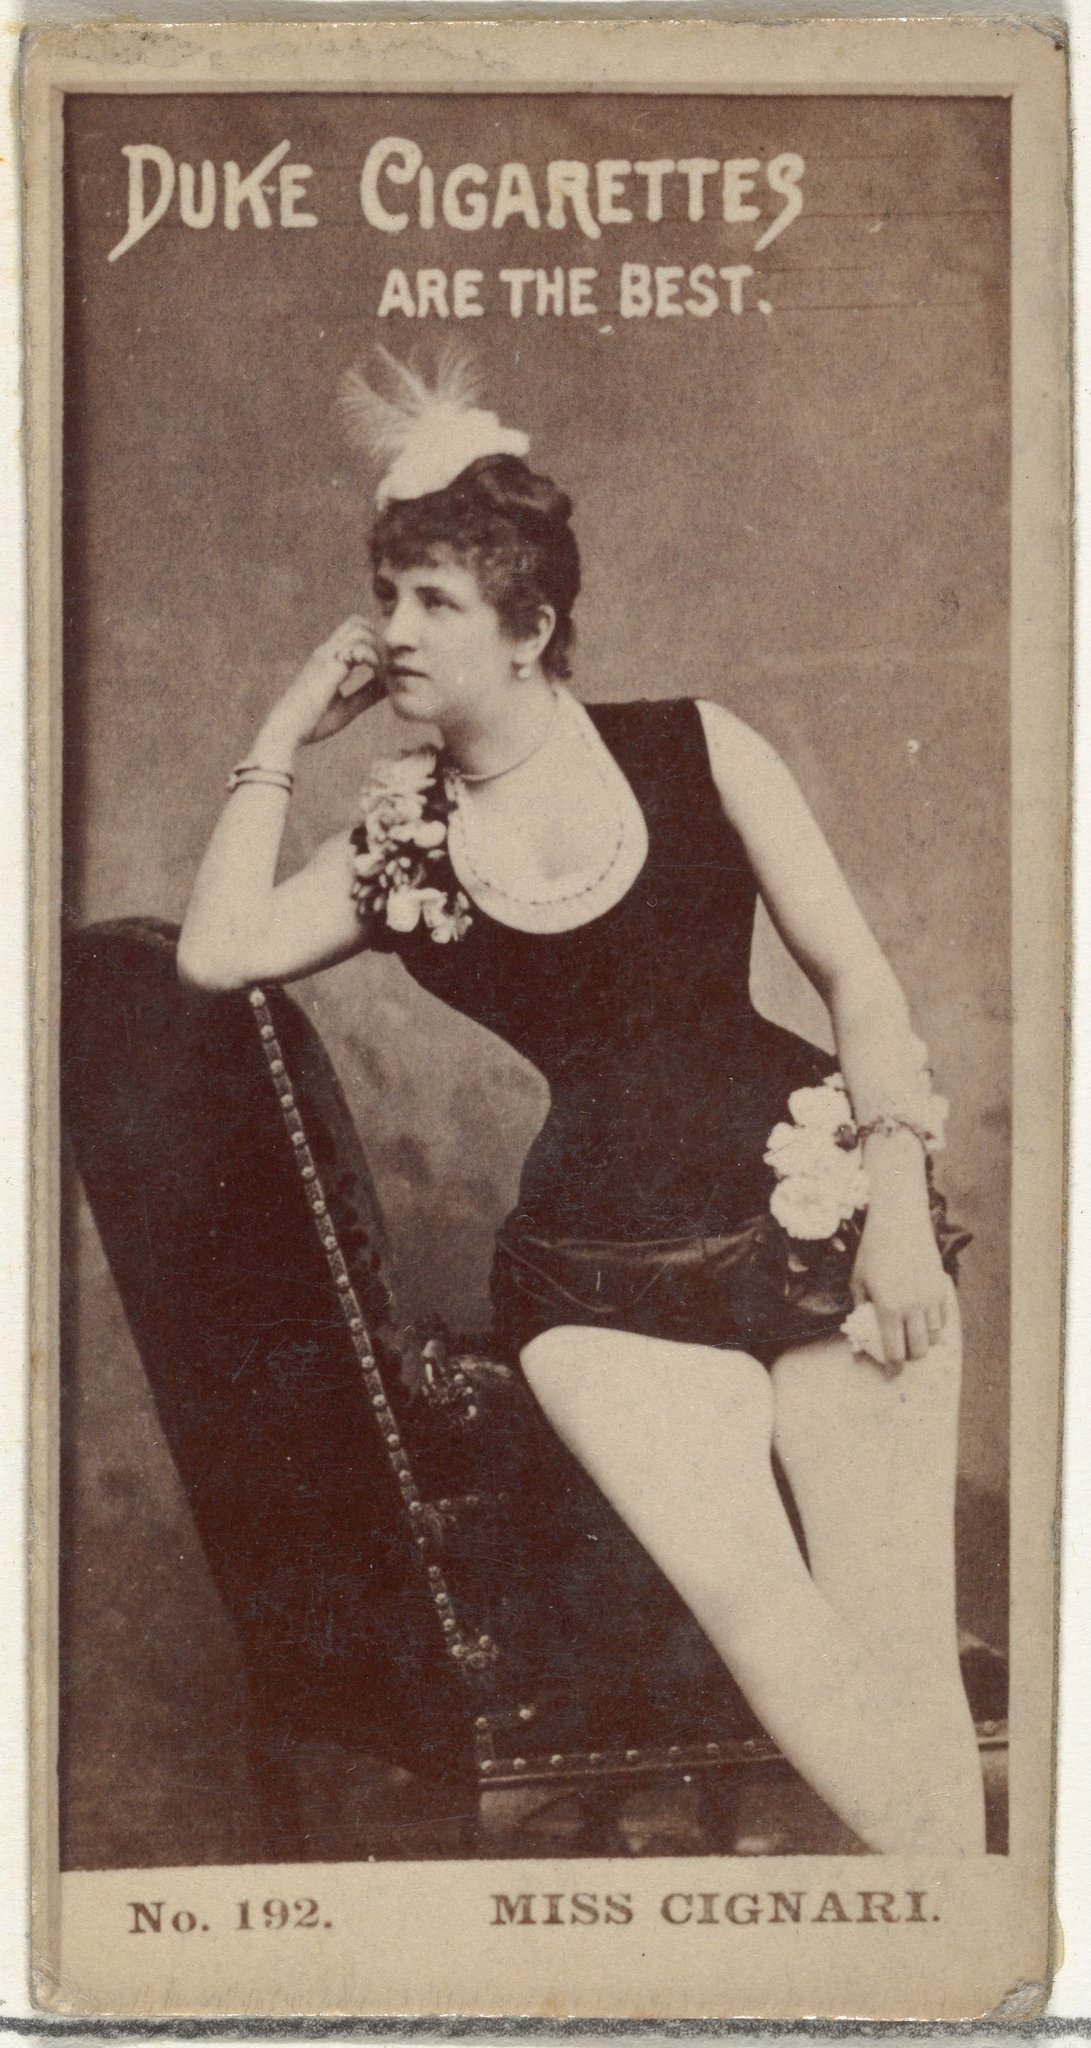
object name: photograph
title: Card Number 192, Miss Cignari, from the Actors and Actresses series (N145-6) issued by Duke Sons & Co. to promote Duke Cigarettes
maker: w. duke, sons & co.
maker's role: publisher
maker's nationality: american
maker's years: 1870-1920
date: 1880-1889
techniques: albumen silver print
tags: portraits,women,actresses